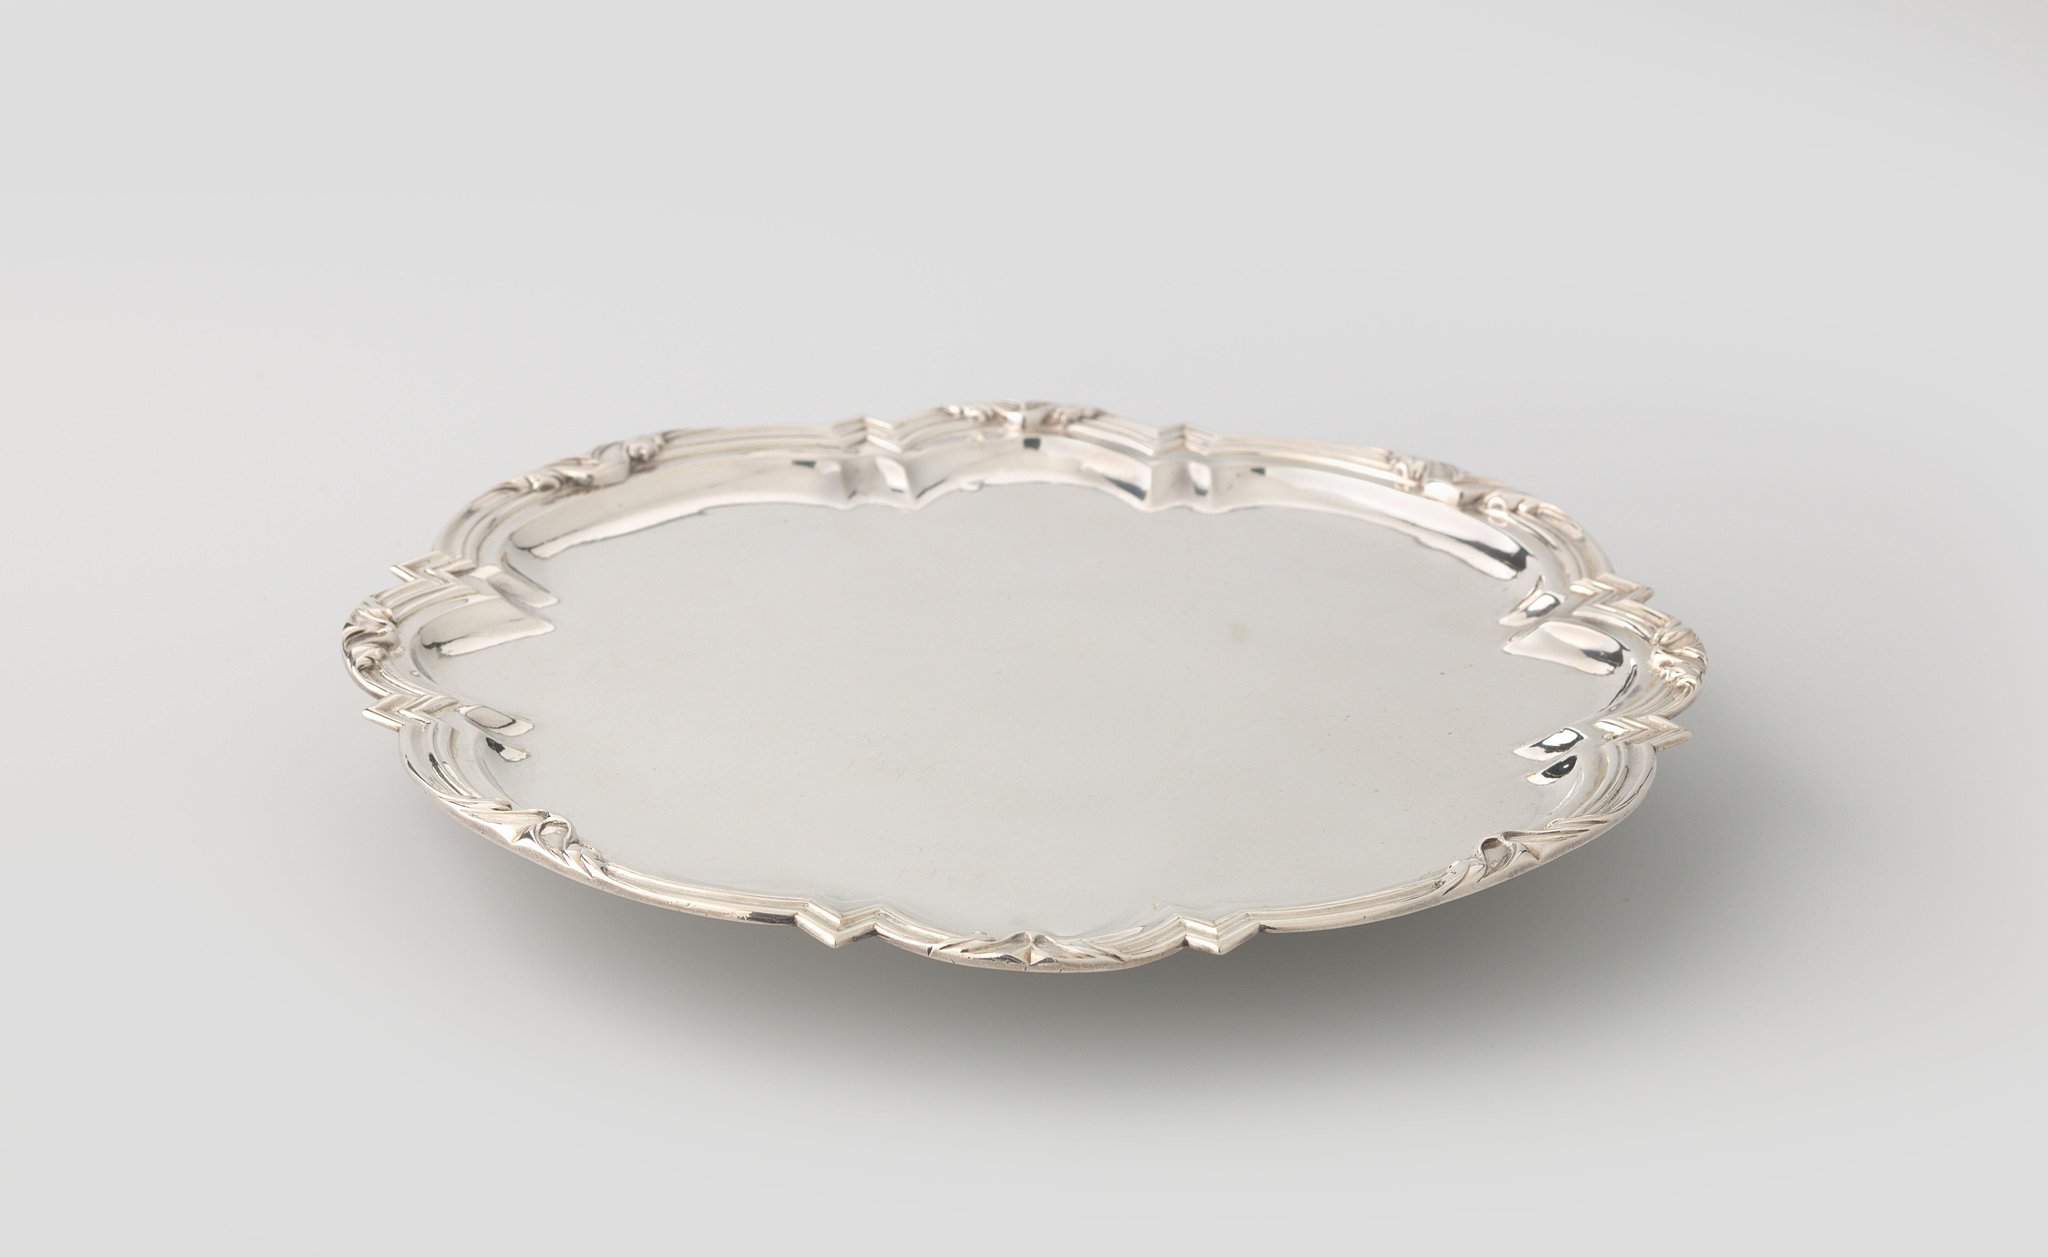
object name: salver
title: Blad, vierzijdig, met afgeronde zijden en hoeken, gescheiden door rechte hoeken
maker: gerrit boldijn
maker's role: silversmith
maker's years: 1694-1742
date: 1726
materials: silver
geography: amsterdam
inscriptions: maker's mark, town mark, alloy mark, : ‘T’, date letter: ‘Q’